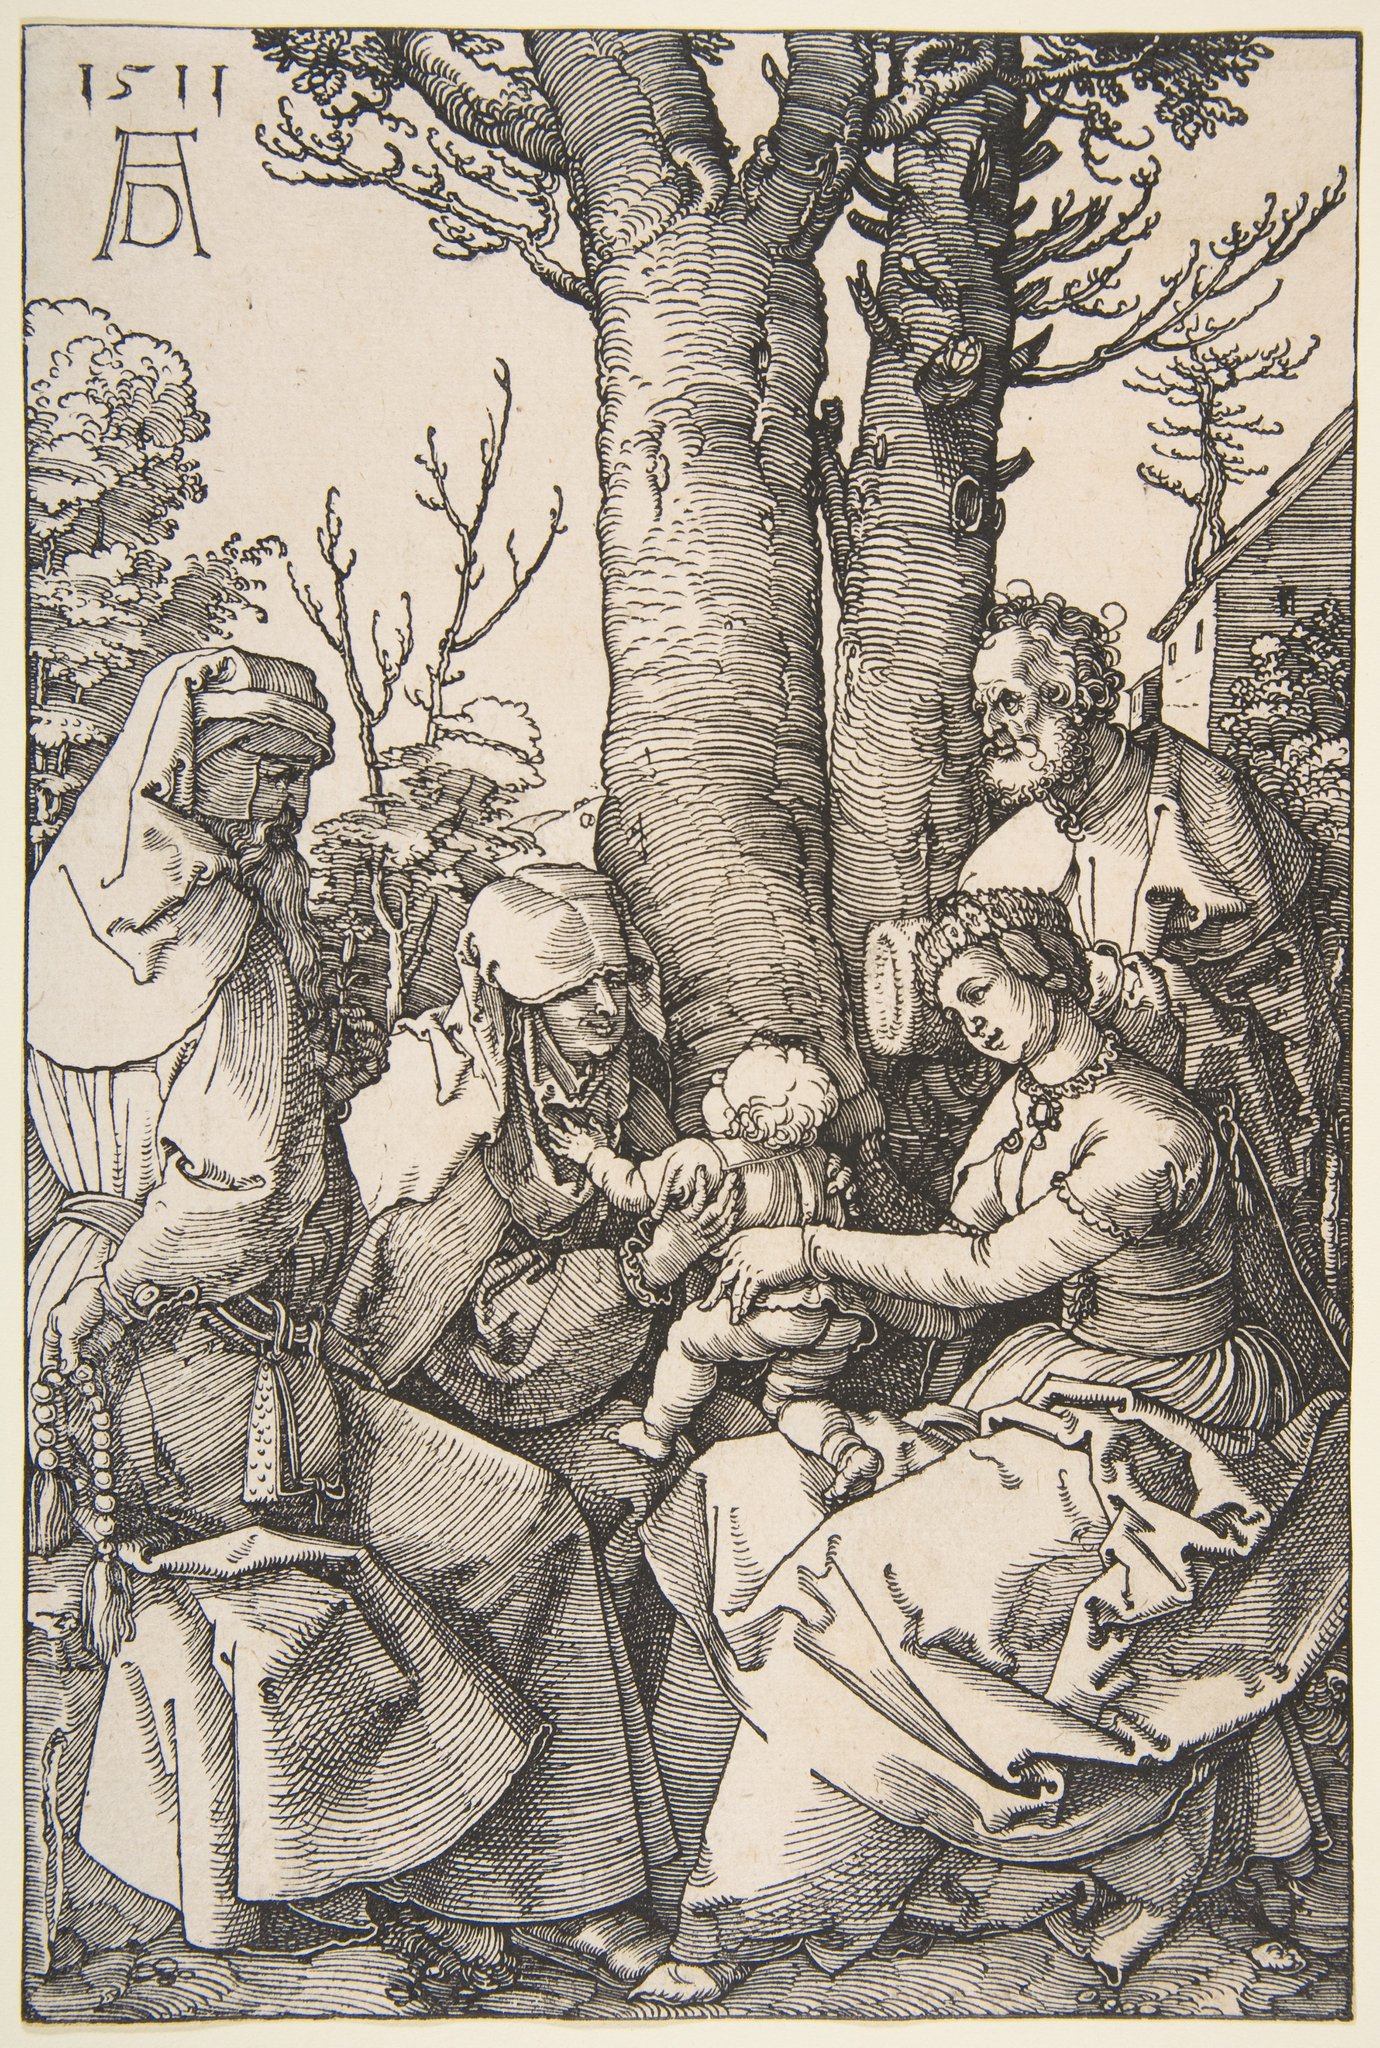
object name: print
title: The Holy Family with Saint Joachim and Saint Anne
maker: albrecht dürer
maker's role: artist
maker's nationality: german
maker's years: 1471-1528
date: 1511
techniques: woodcut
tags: infants,men,holy family,saint anne,saints